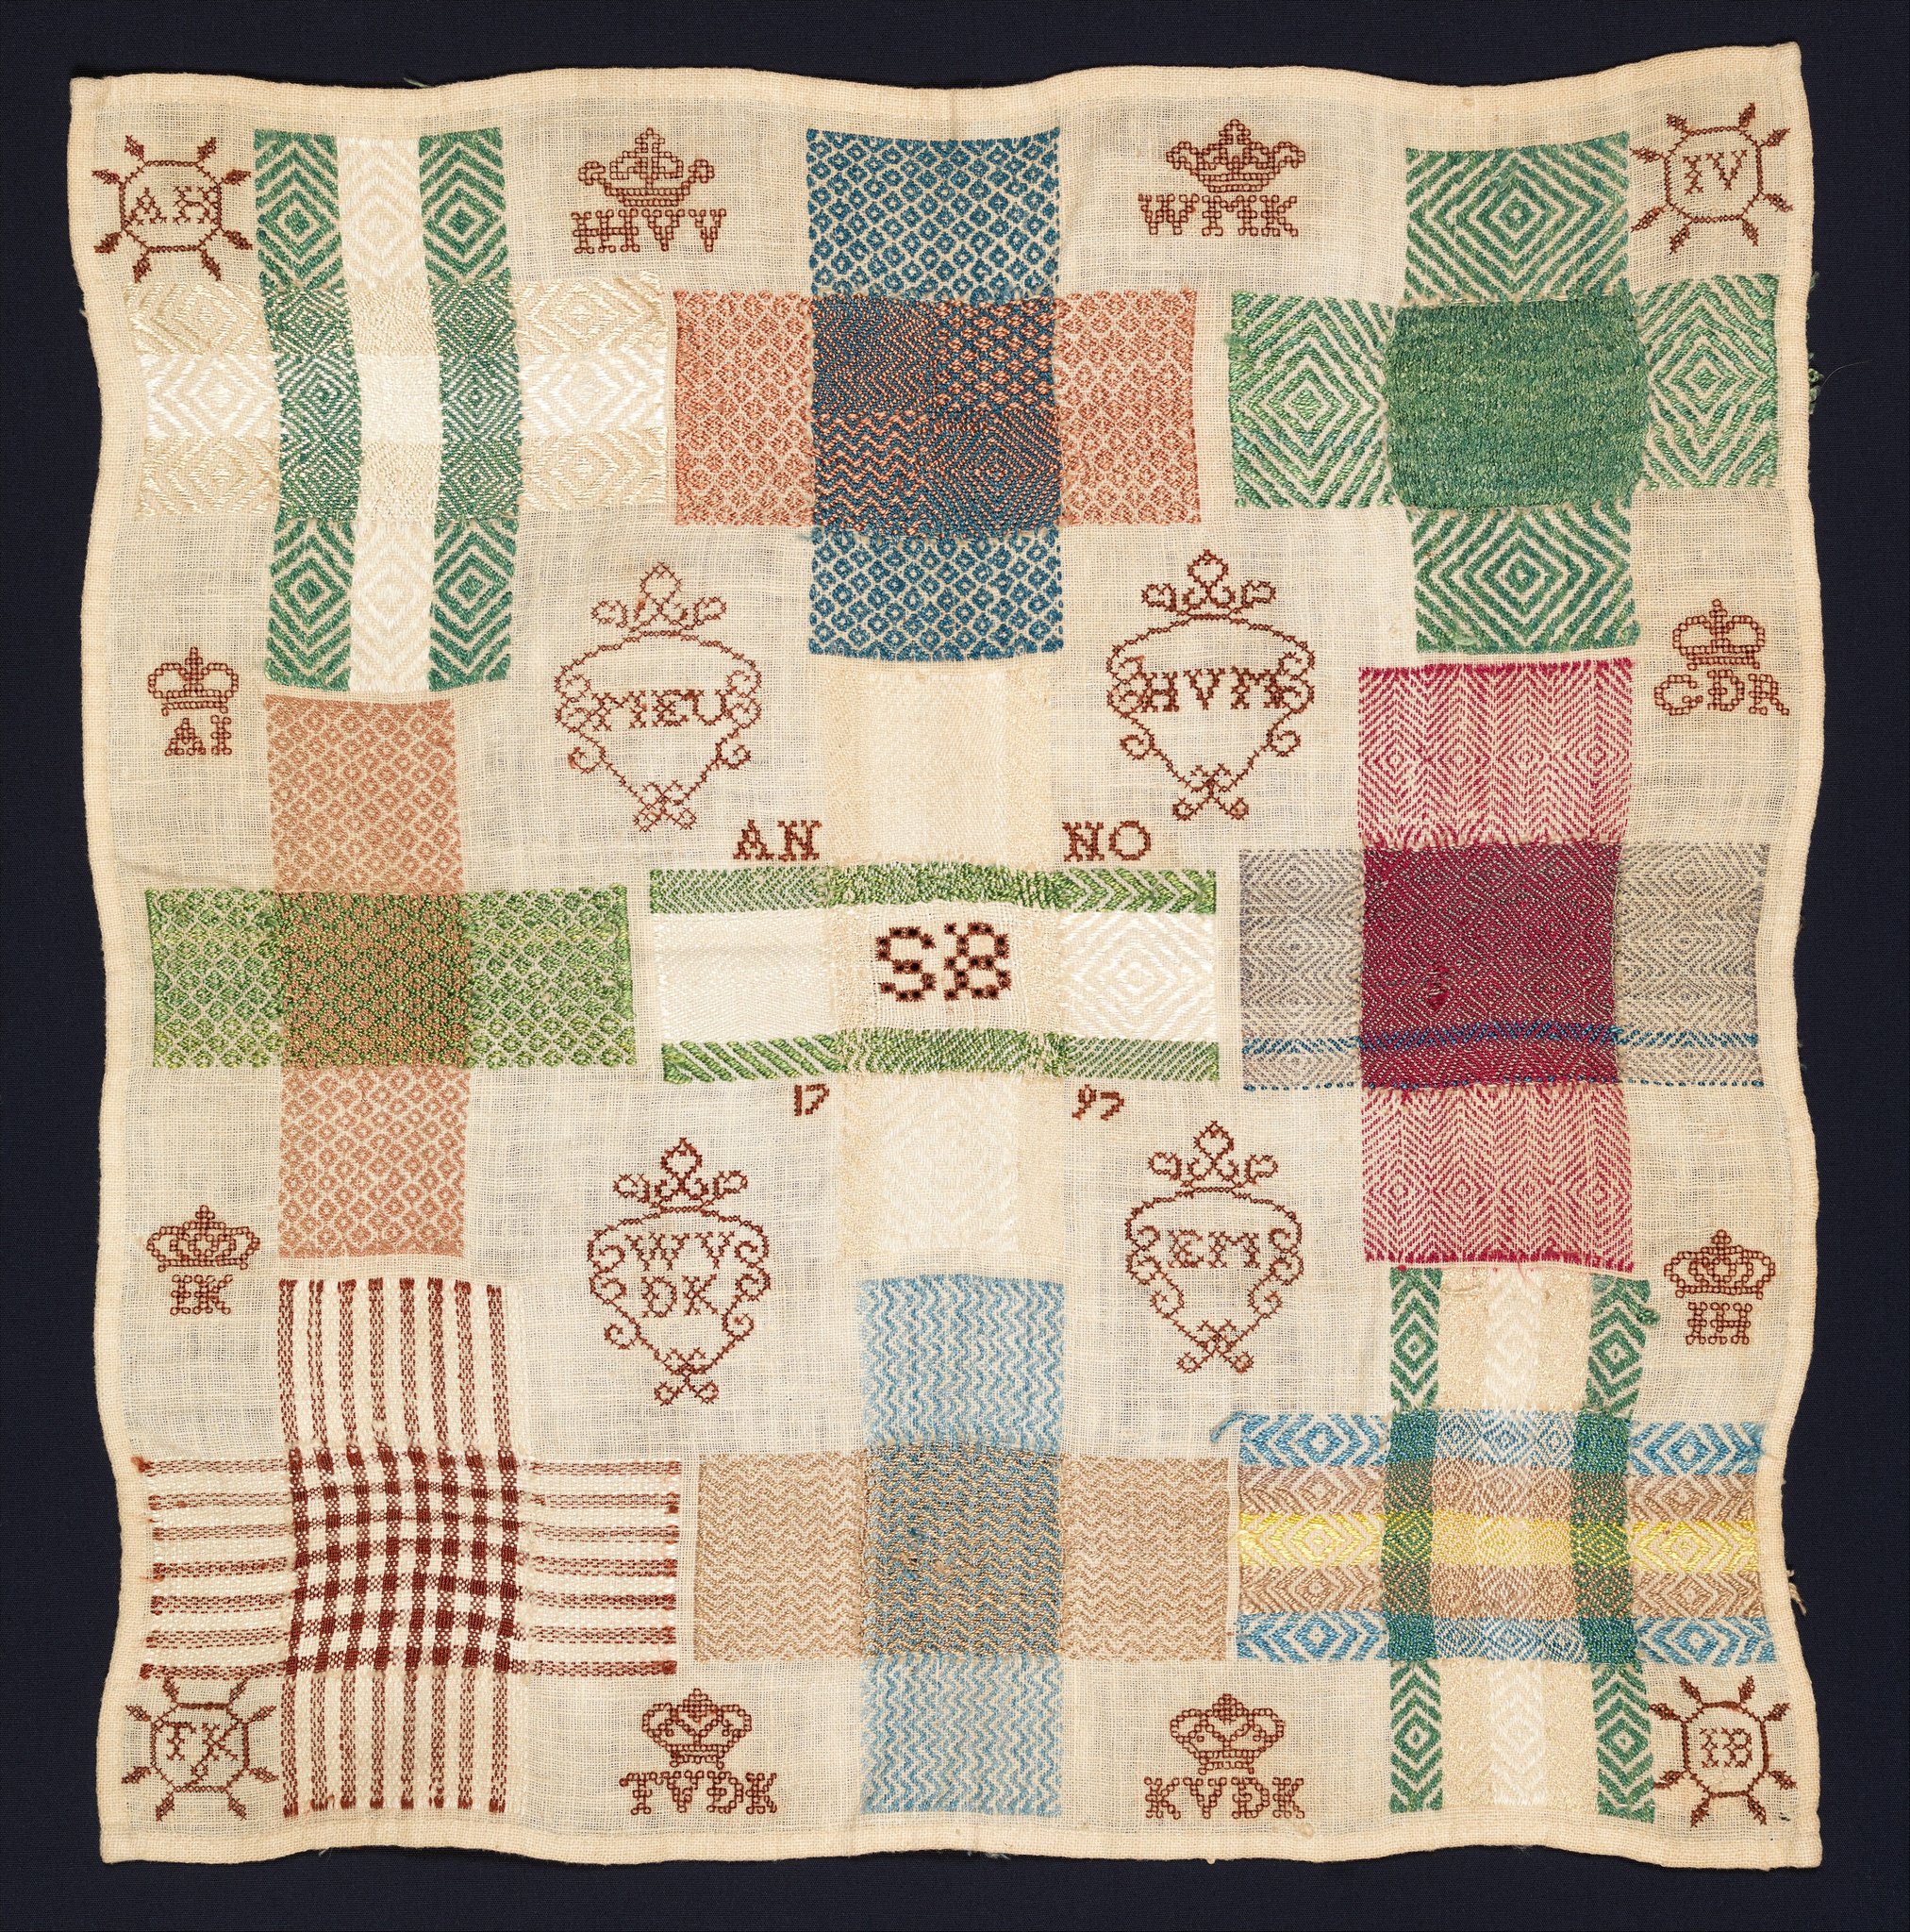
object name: sampler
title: Darning sampler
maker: treijntje van der kamp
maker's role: artist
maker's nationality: dutch, active 1797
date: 1797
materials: cotton, silk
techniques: embroidery